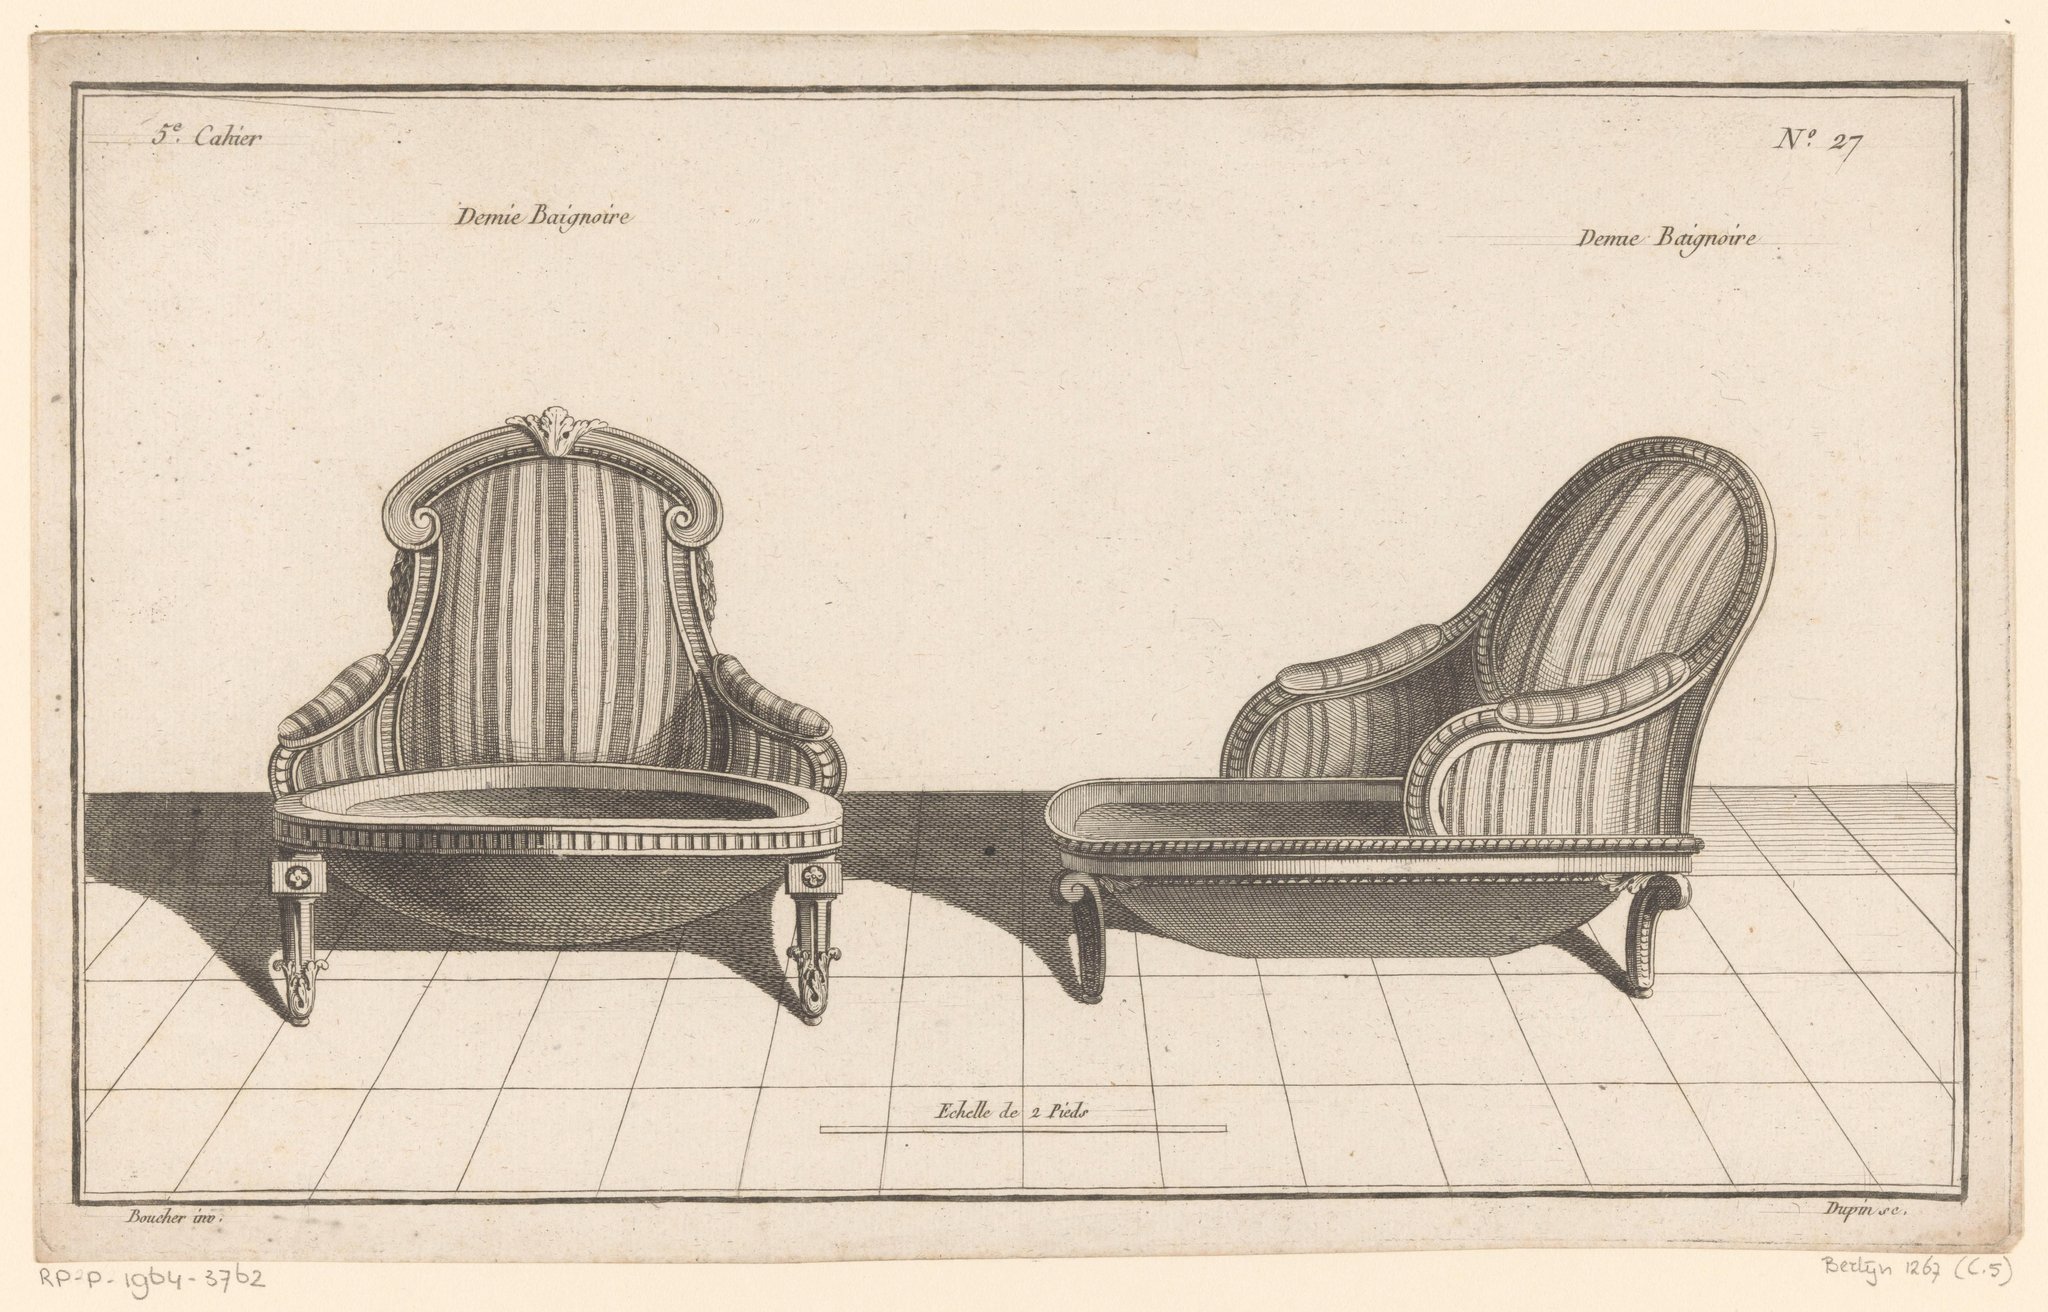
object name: print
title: Twee kleine baden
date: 1772-1779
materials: paper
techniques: engraving, etching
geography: paris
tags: bath-tub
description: Twee kleine geornamenteerde baden met rugleuning. Prentnummer 27.